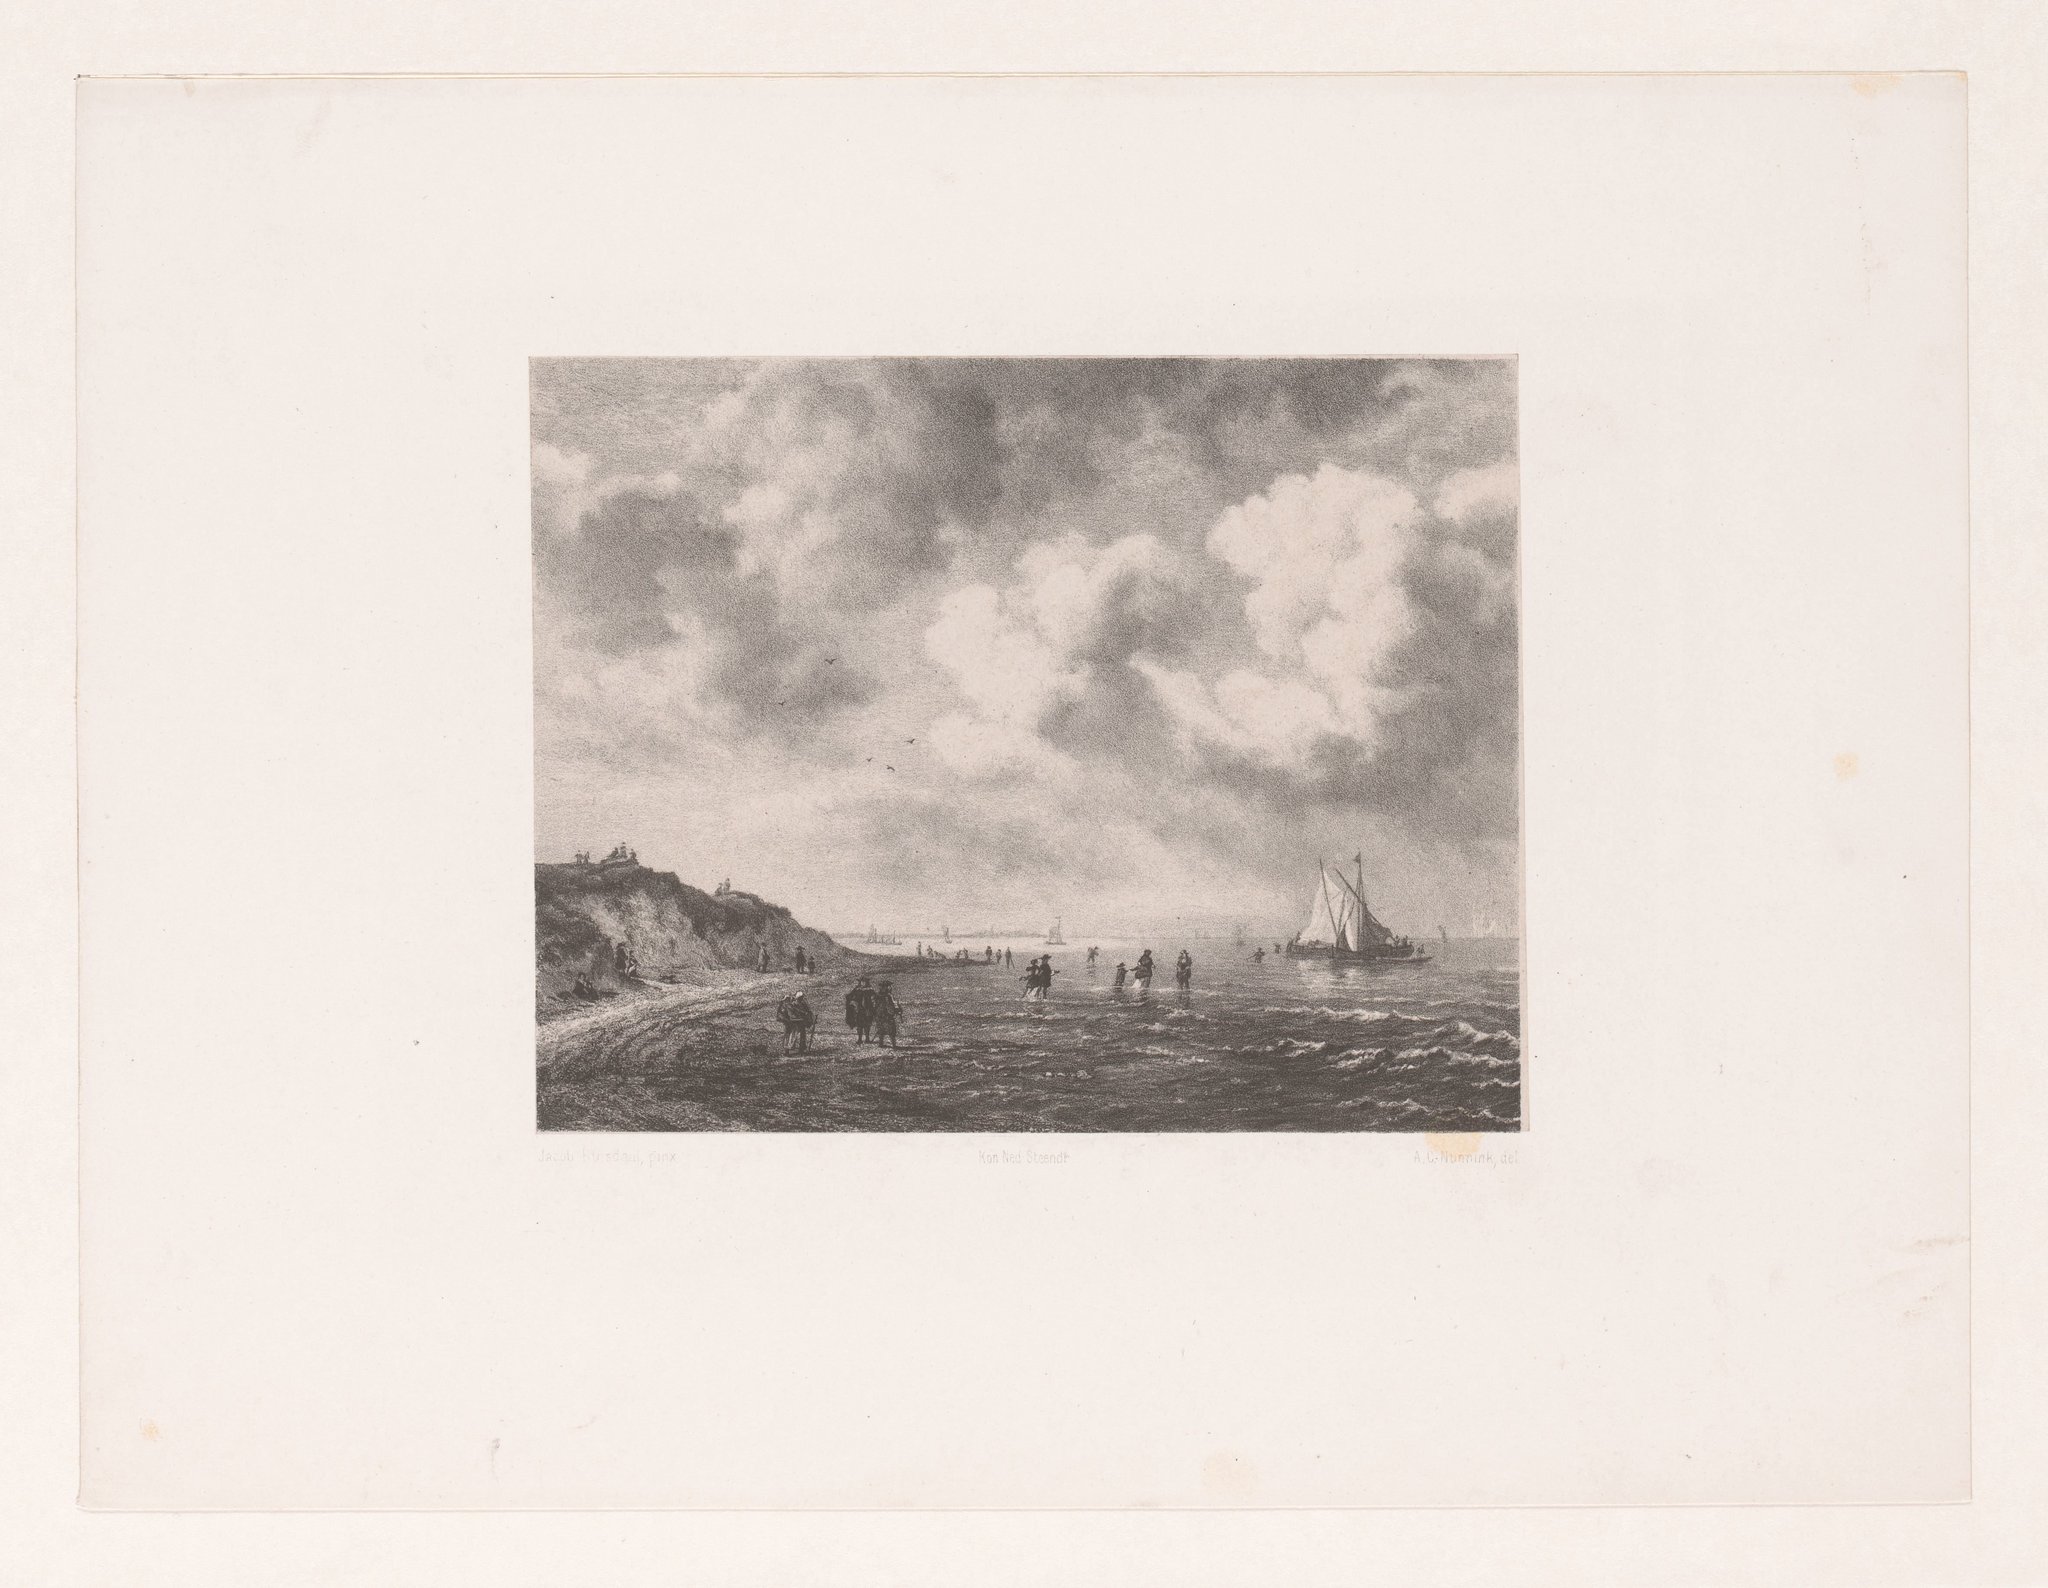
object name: print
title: Mensen op het strand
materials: paper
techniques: lithograph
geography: the hague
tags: sailing-ship, sailing-boat, beach, sea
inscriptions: collector's mark: Lugt 2228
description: Mensen op het strand en in het water. Rechts en in de achtergrond zeilboten op zee.